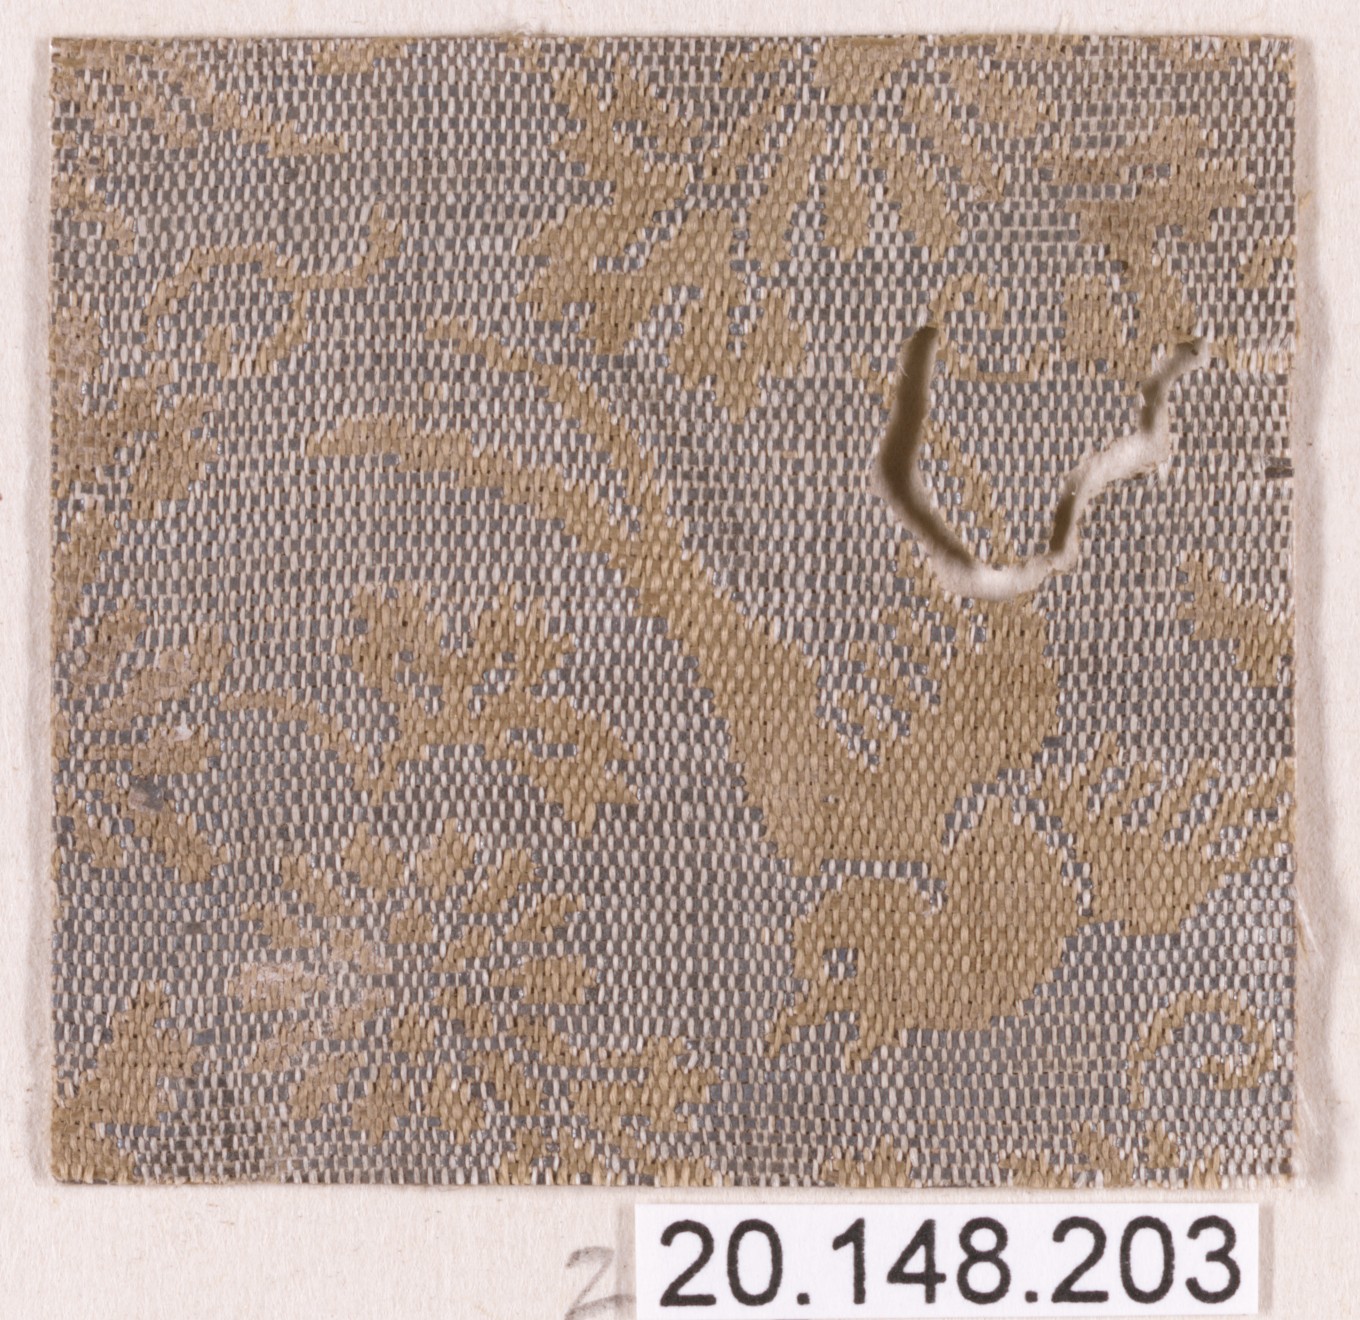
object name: piece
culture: japanese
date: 1701-1800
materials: silk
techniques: compound weave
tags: flowers,leaves